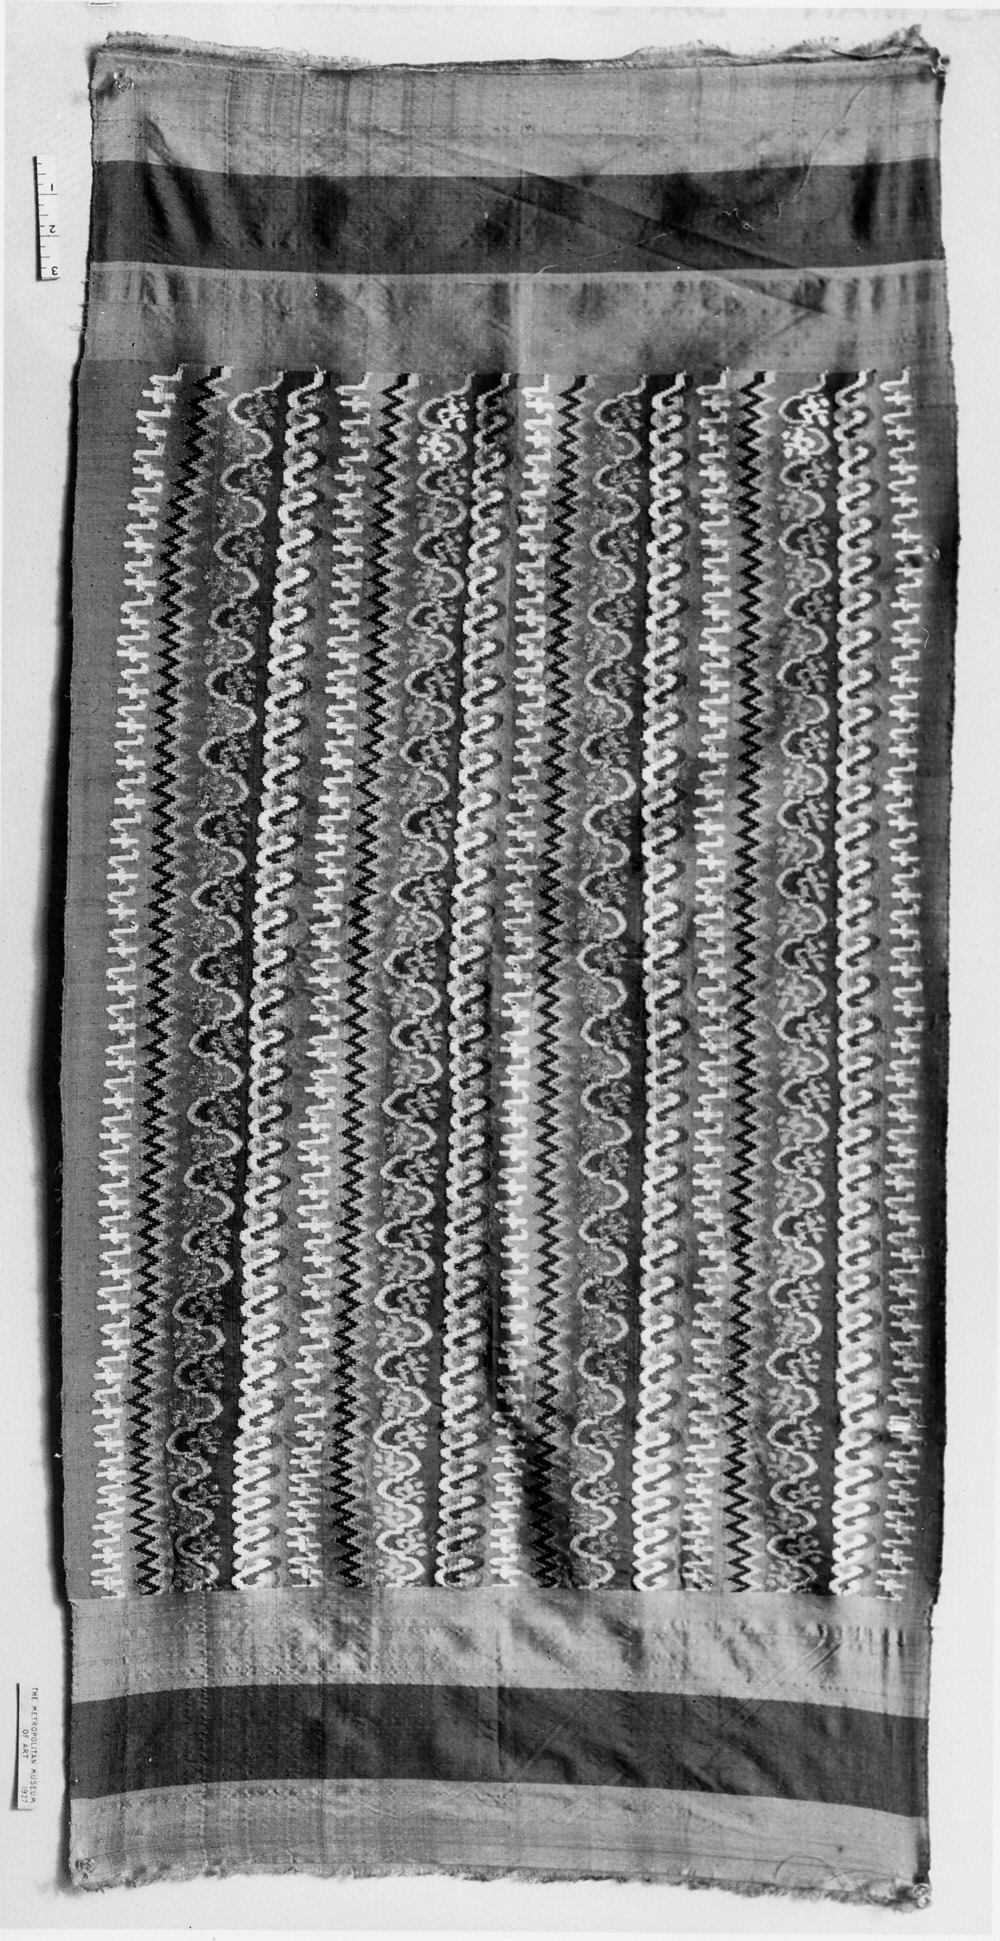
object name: skirt panel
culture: burmese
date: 1801-1900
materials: metal thread, silk